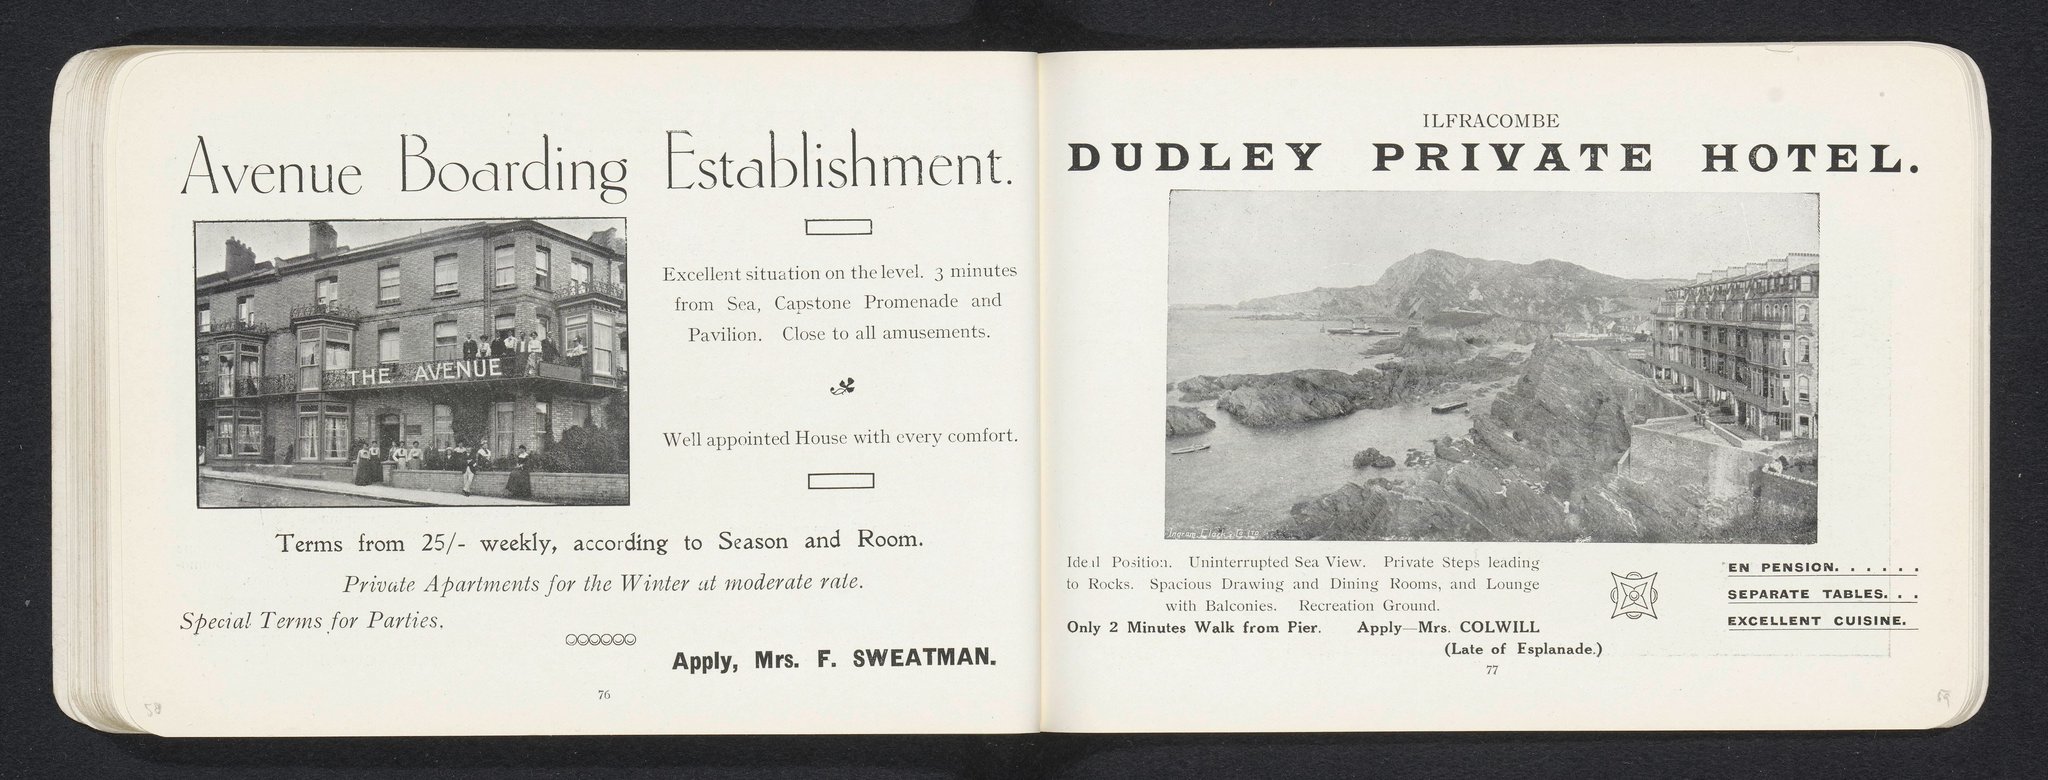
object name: page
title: Gezicht op Ilfracombe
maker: Anonymous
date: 1900-1920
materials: paper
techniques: autotype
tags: façade (of house or building), hotel, hostelry, inn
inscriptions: inscription: ‘Ilfracombe (...) (Late of esplanade.)’